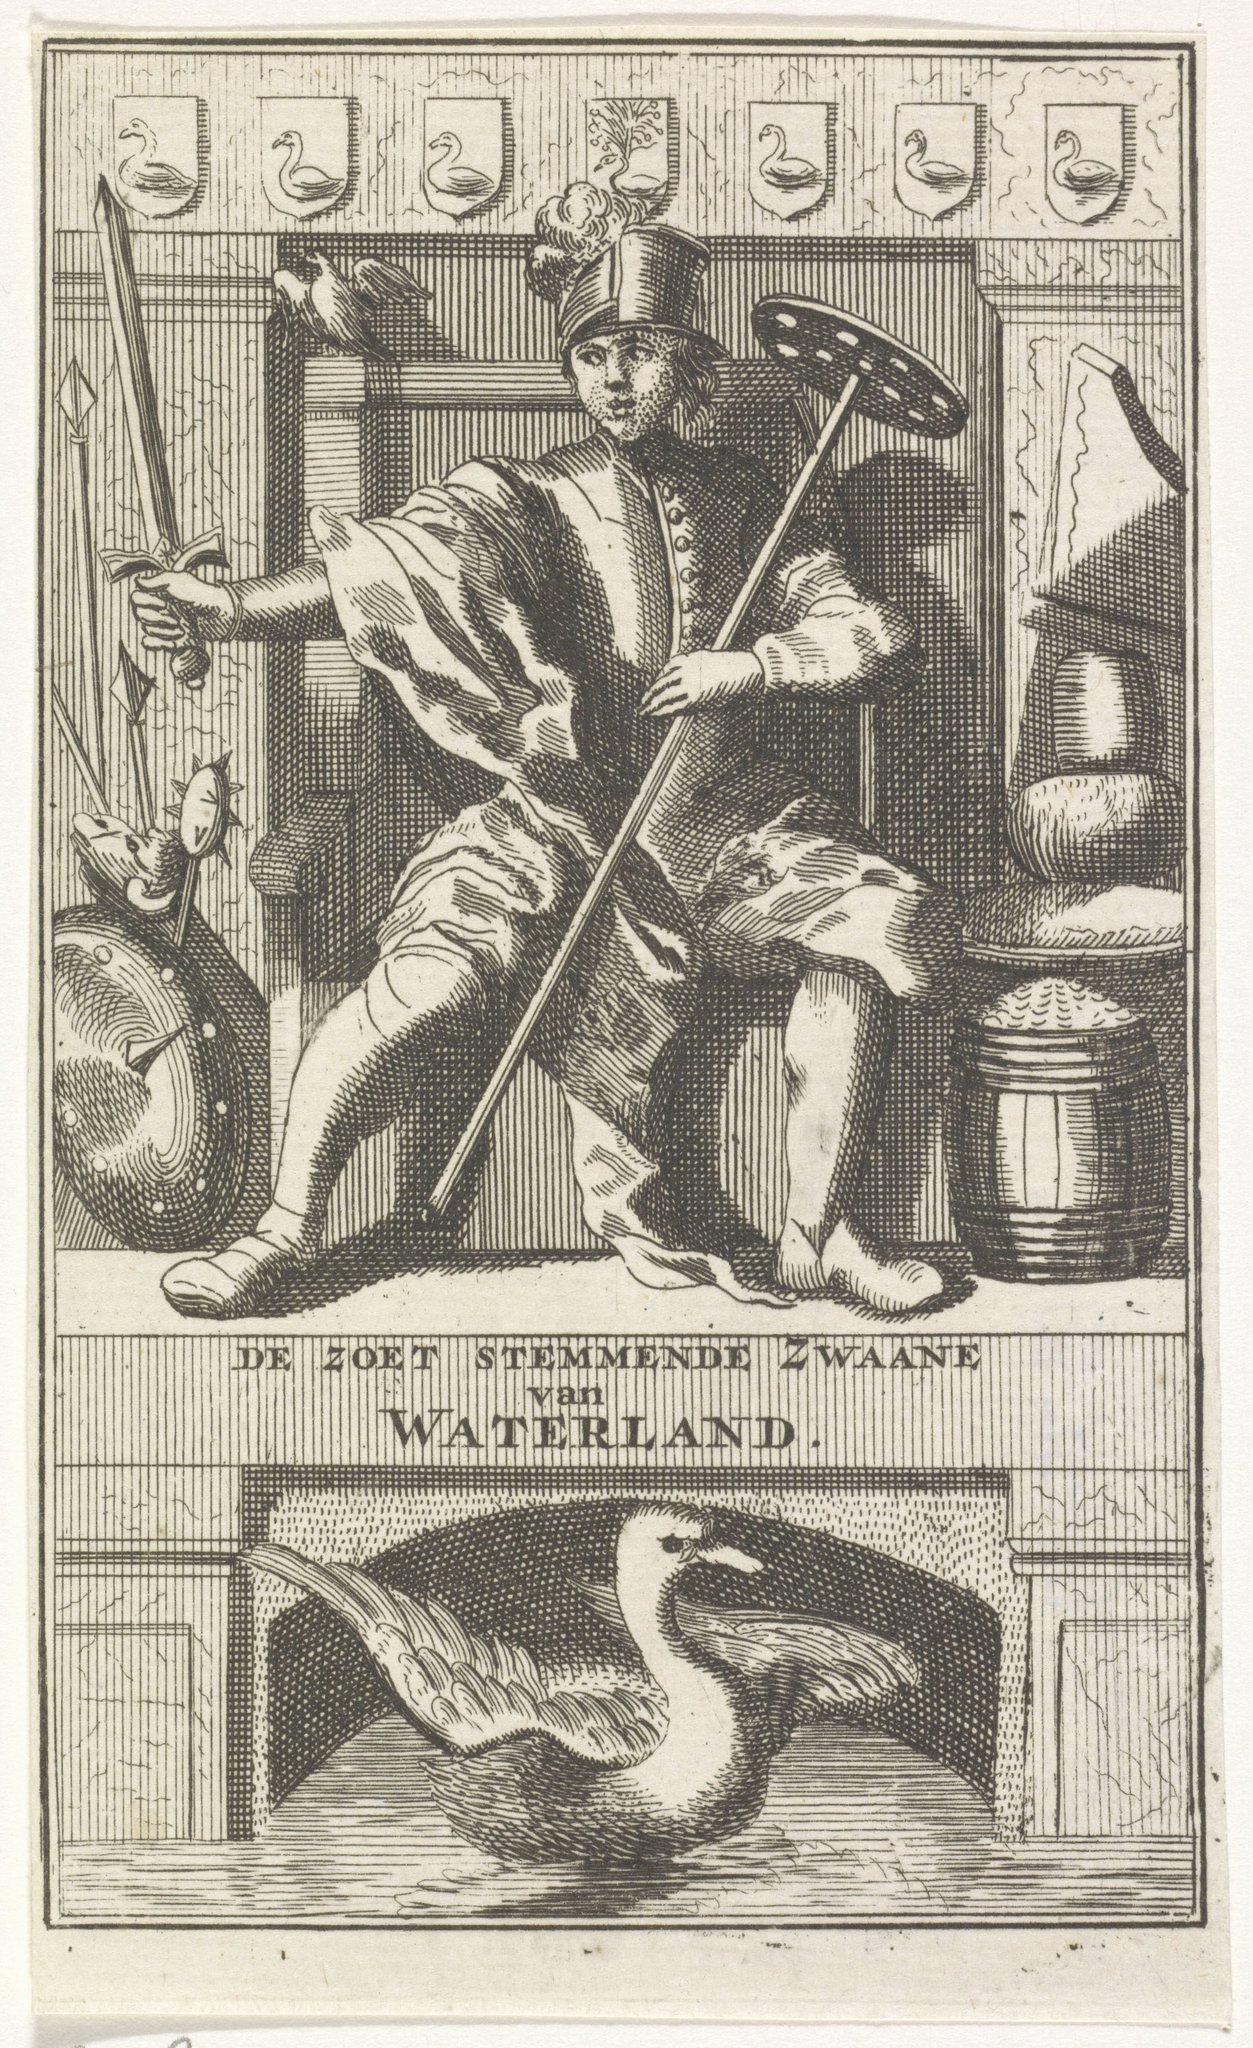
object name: print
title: Strijder met zwaan van Waterland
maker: Anonymous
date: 1702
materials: paper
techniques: etching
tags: water-birds: swan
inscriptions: collector's mark: Lugt 2228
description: Een strijder zit met een zwaard in de hand. Aan weerszijden ander wapentuig. Boven hem verschillende wapenschilden van dorpen en steden in de regio Waterland. Onderaan de zwaan van Waterland. Titelpagina voor het boek De zoet stemmende zwaane van Waterland.